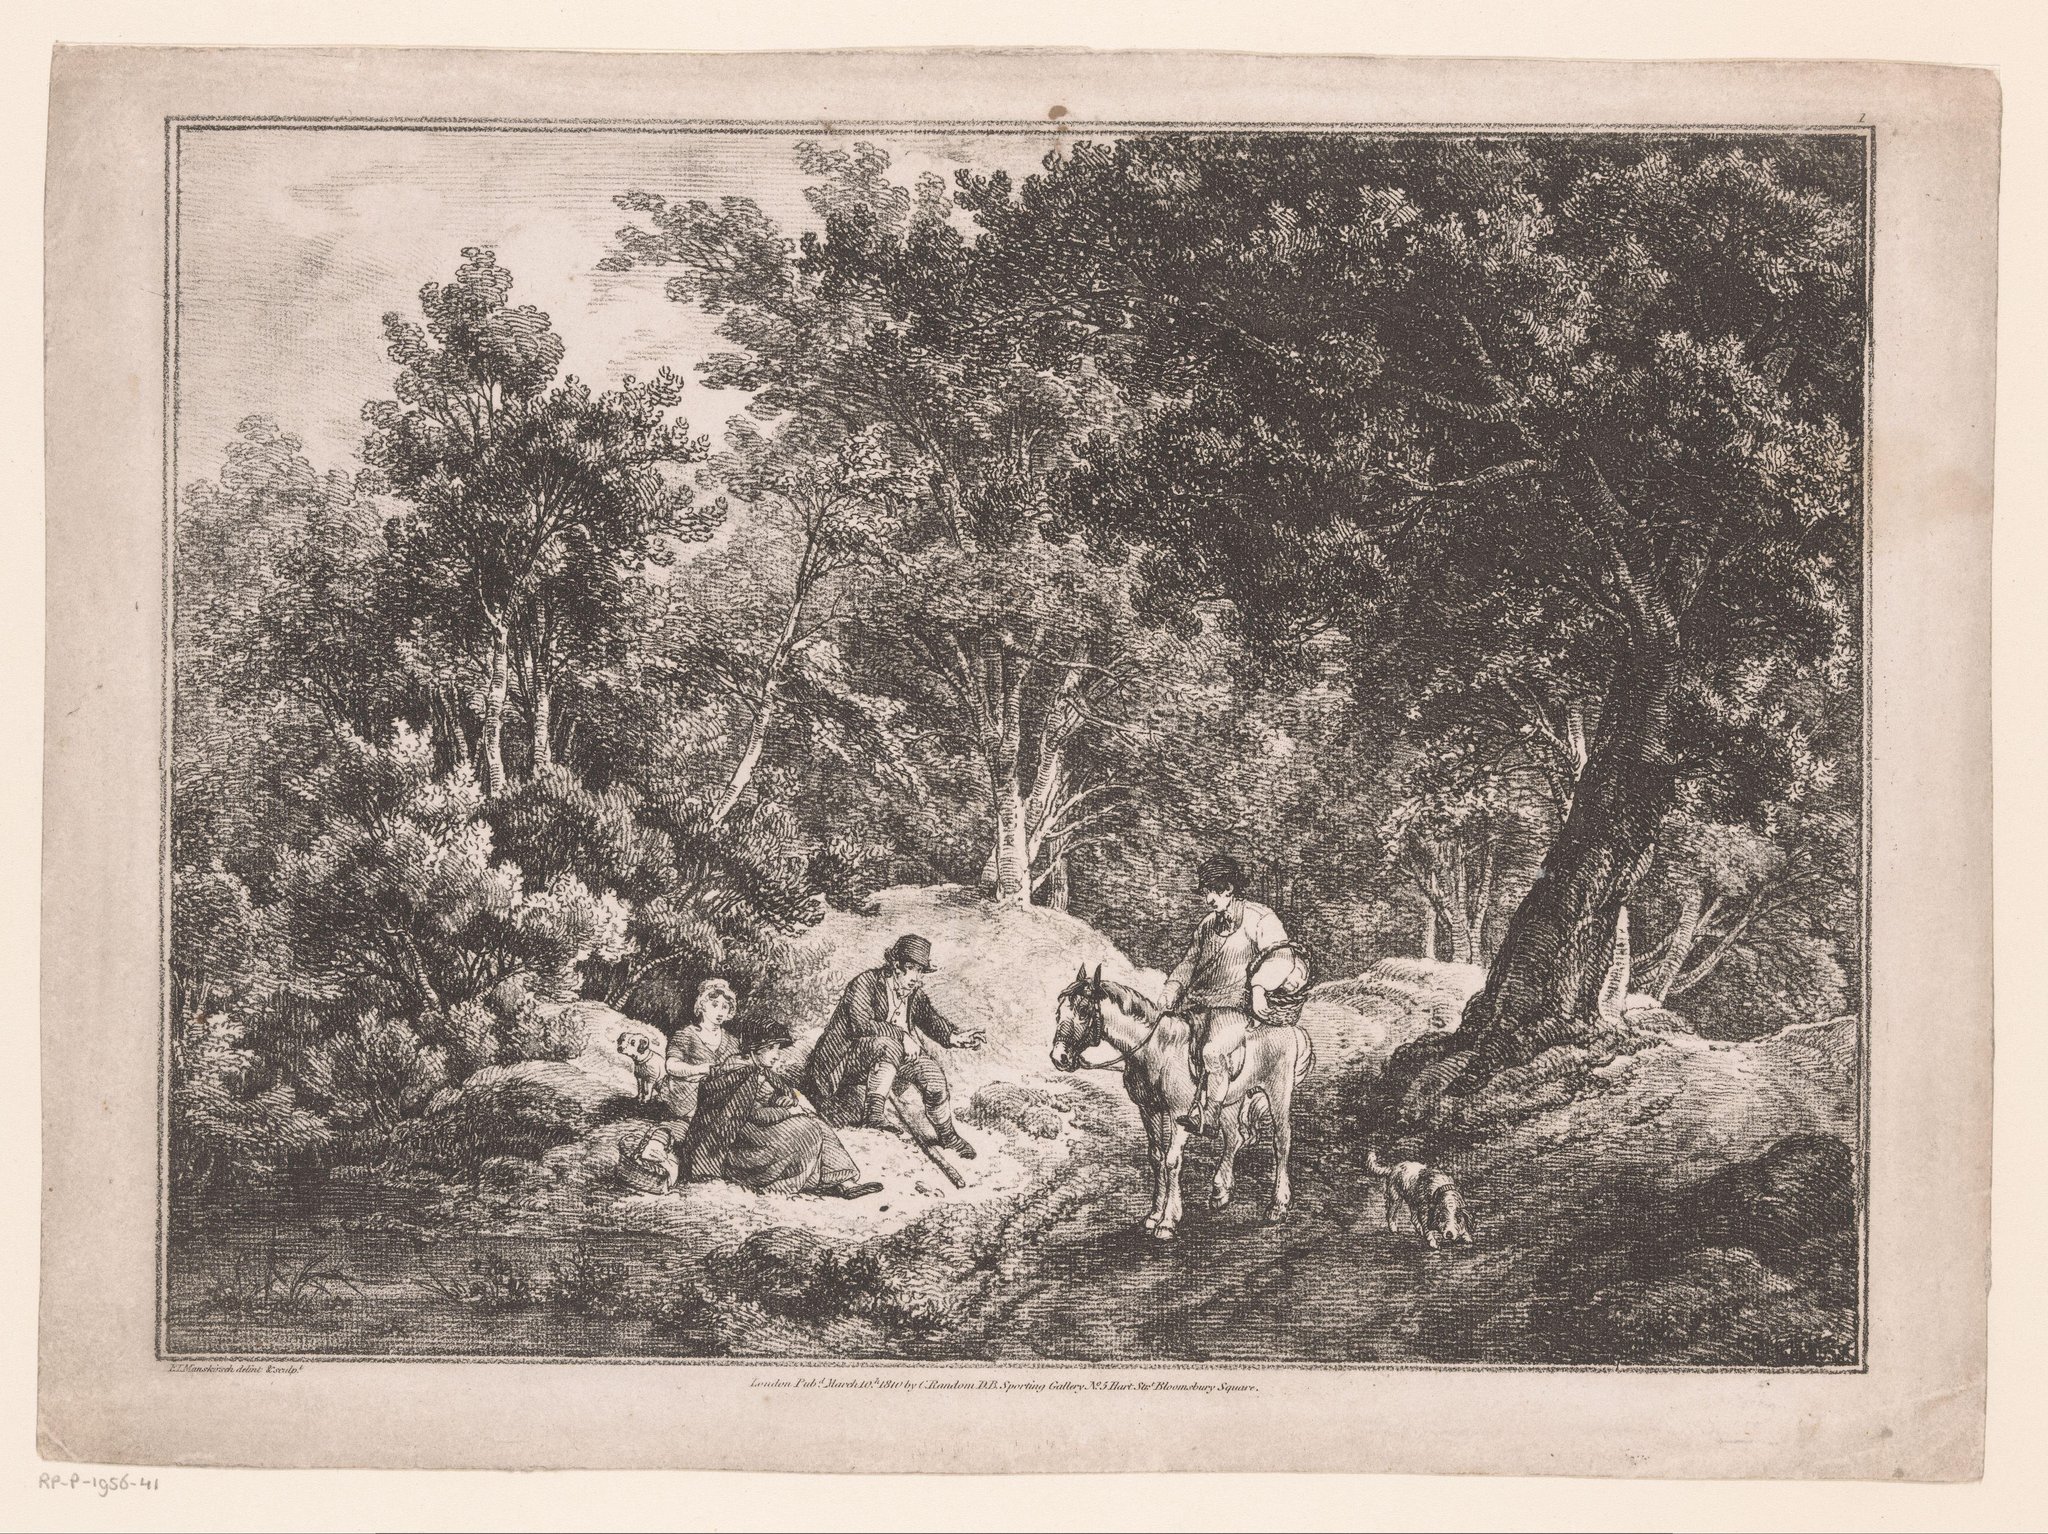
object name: print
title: Zes landschappen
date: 1810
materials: paper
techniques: soft ground etching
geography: london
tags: forest, wood, conversation, dialogue; conversation piece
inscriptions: collector's mark: Lugt 2228, collector's mark: Lugt 2760, inscription: ‘No 23 Wood June ...’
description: Boslandschap met drie zittende personen. De man is in gesprek met een persoon te paard. Hij heeft een mand om zijn arm.